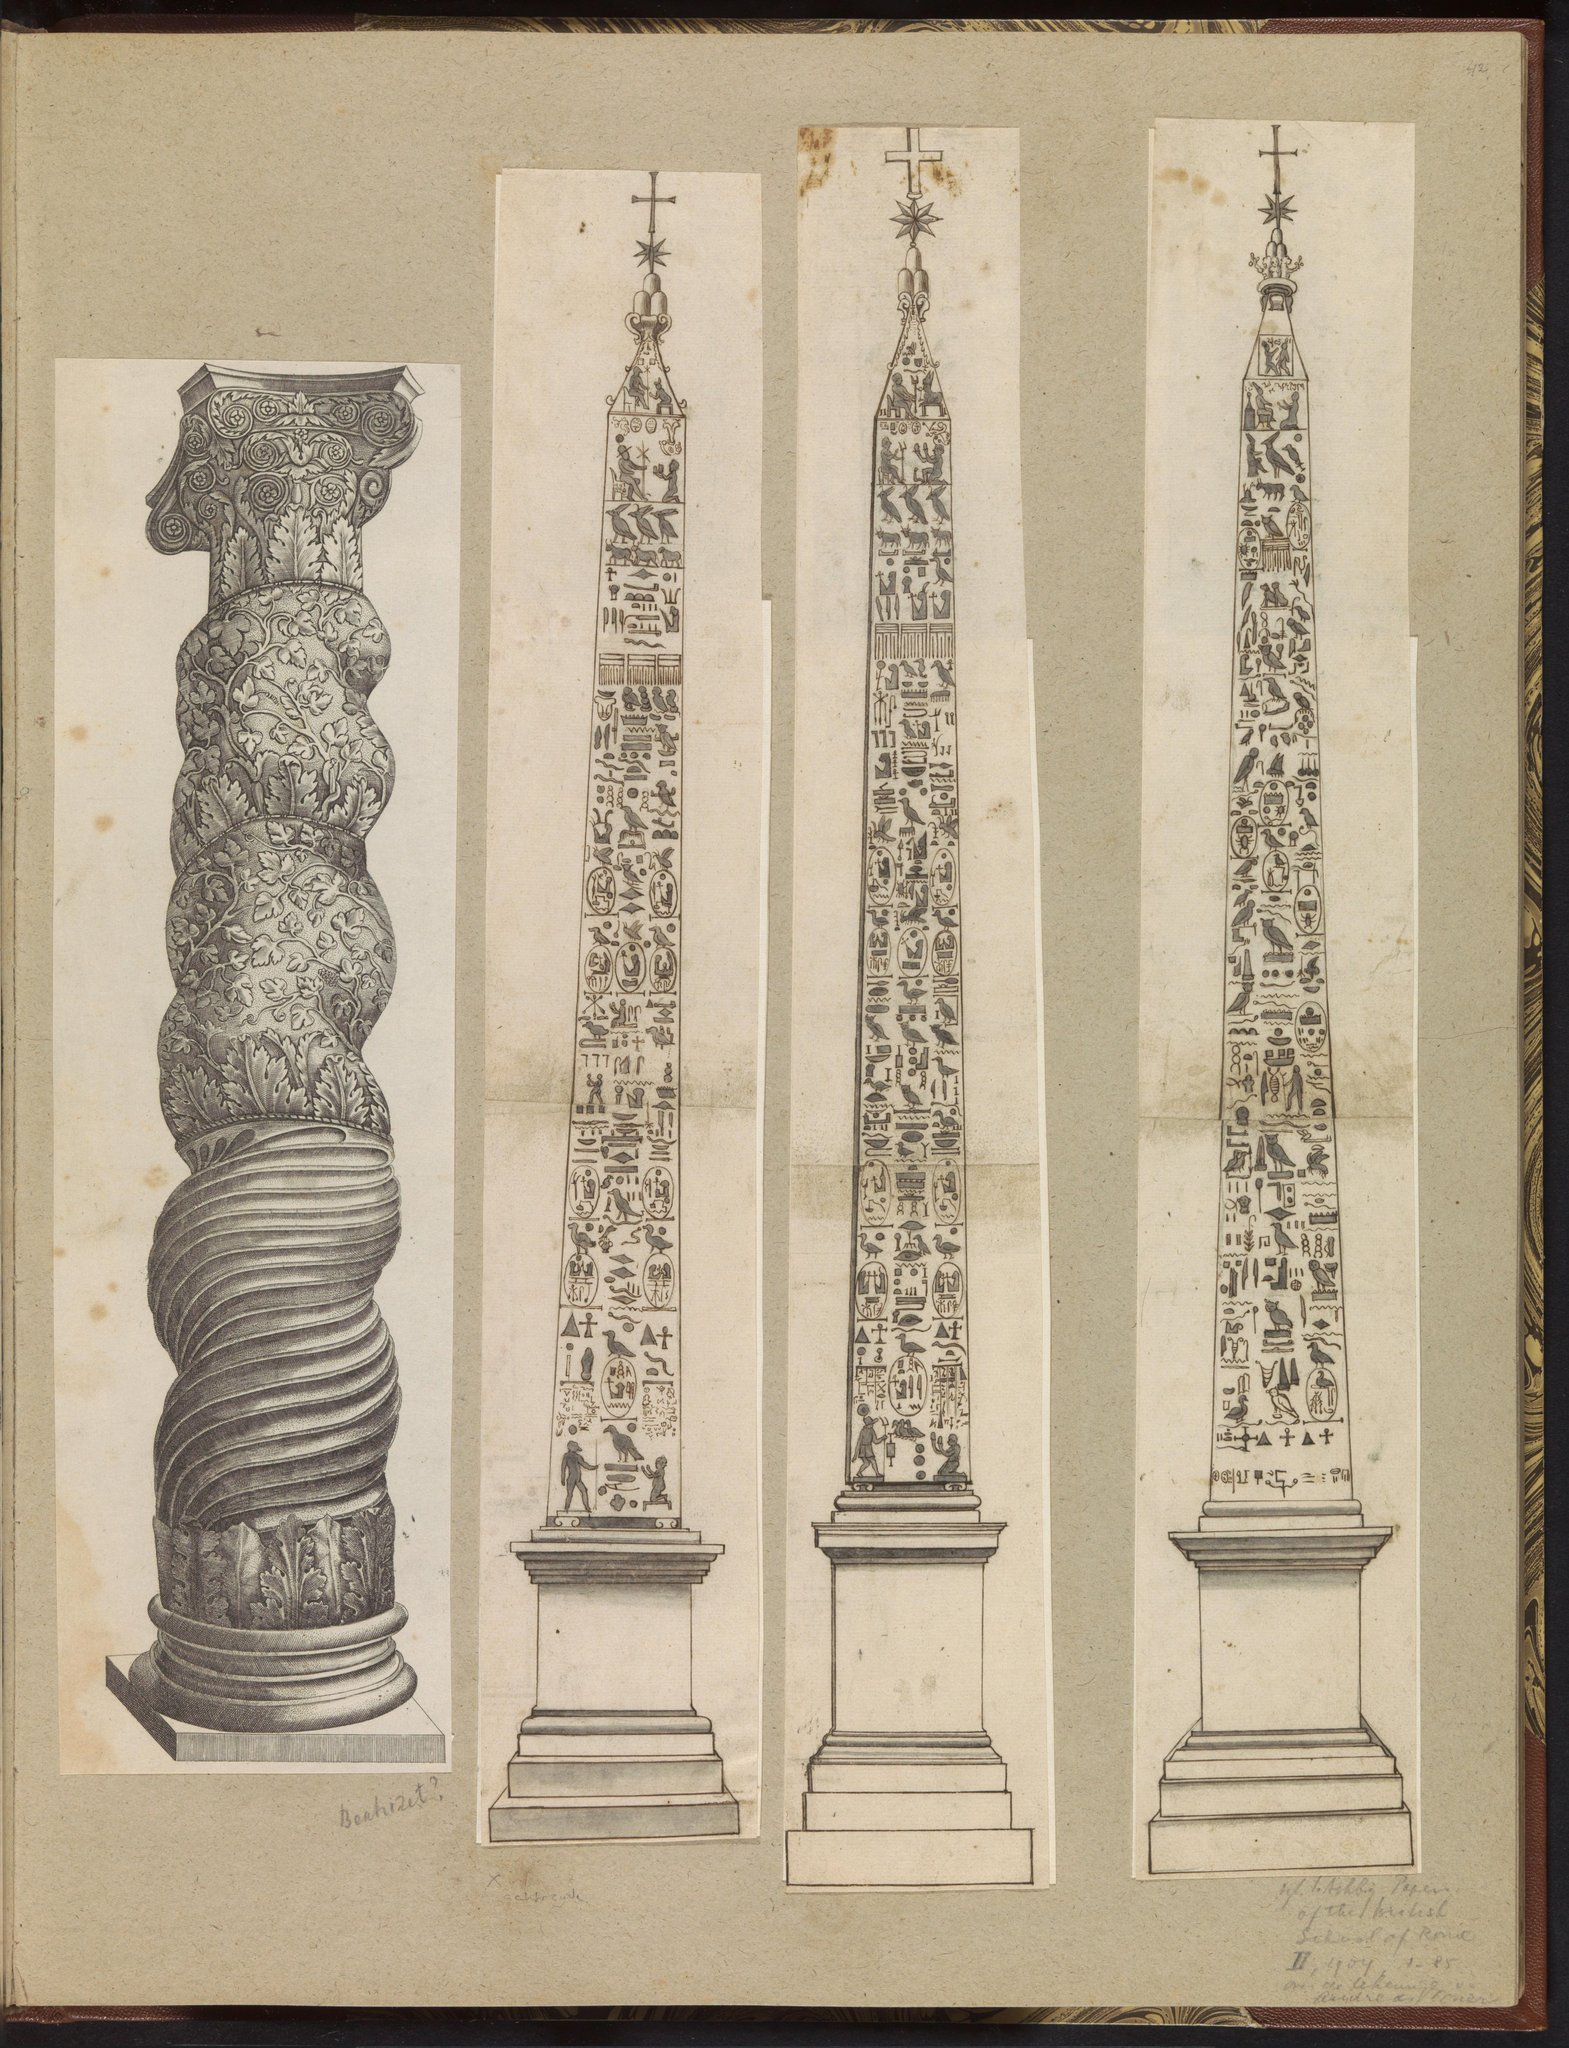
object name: prentrecueil, prentenalbum, prentalbum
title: Album met Romeinse tempels, paleizen, triomfbogen en andere monumenten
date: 1629-1708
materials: ink, leather, paper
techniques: bookbinding, brush, engraving, etching, marbling, pen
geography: italy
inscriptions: inscription: ‘No. 11/ Eenige Roomse Antique tempels/ schouburge. renbaane. erepoorte/ paleyse. statue. en andere diergelyke/ te saame’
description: Album met 86 etsen en gravures en drie tekeningen op 70 bladen. Het album begint met vijf lege bladen en eindigt met zeven lege bladen. Het album bevat dus in totaal 82 bladen. Het album bevat voornamelijk prenten uit het prentcorpus de 'Speculum Romanae Magnificentiae' en prenten uit de reeks 'Antiquae Urbis Splendor' door Giacomo Lauro. Het is een factice album, dat wil zeggen: een door een verzamelaar of eigenaar van de prenten samengesteld album. Een halfleren en met imitatie gemarmerd stroompapier beklede band.